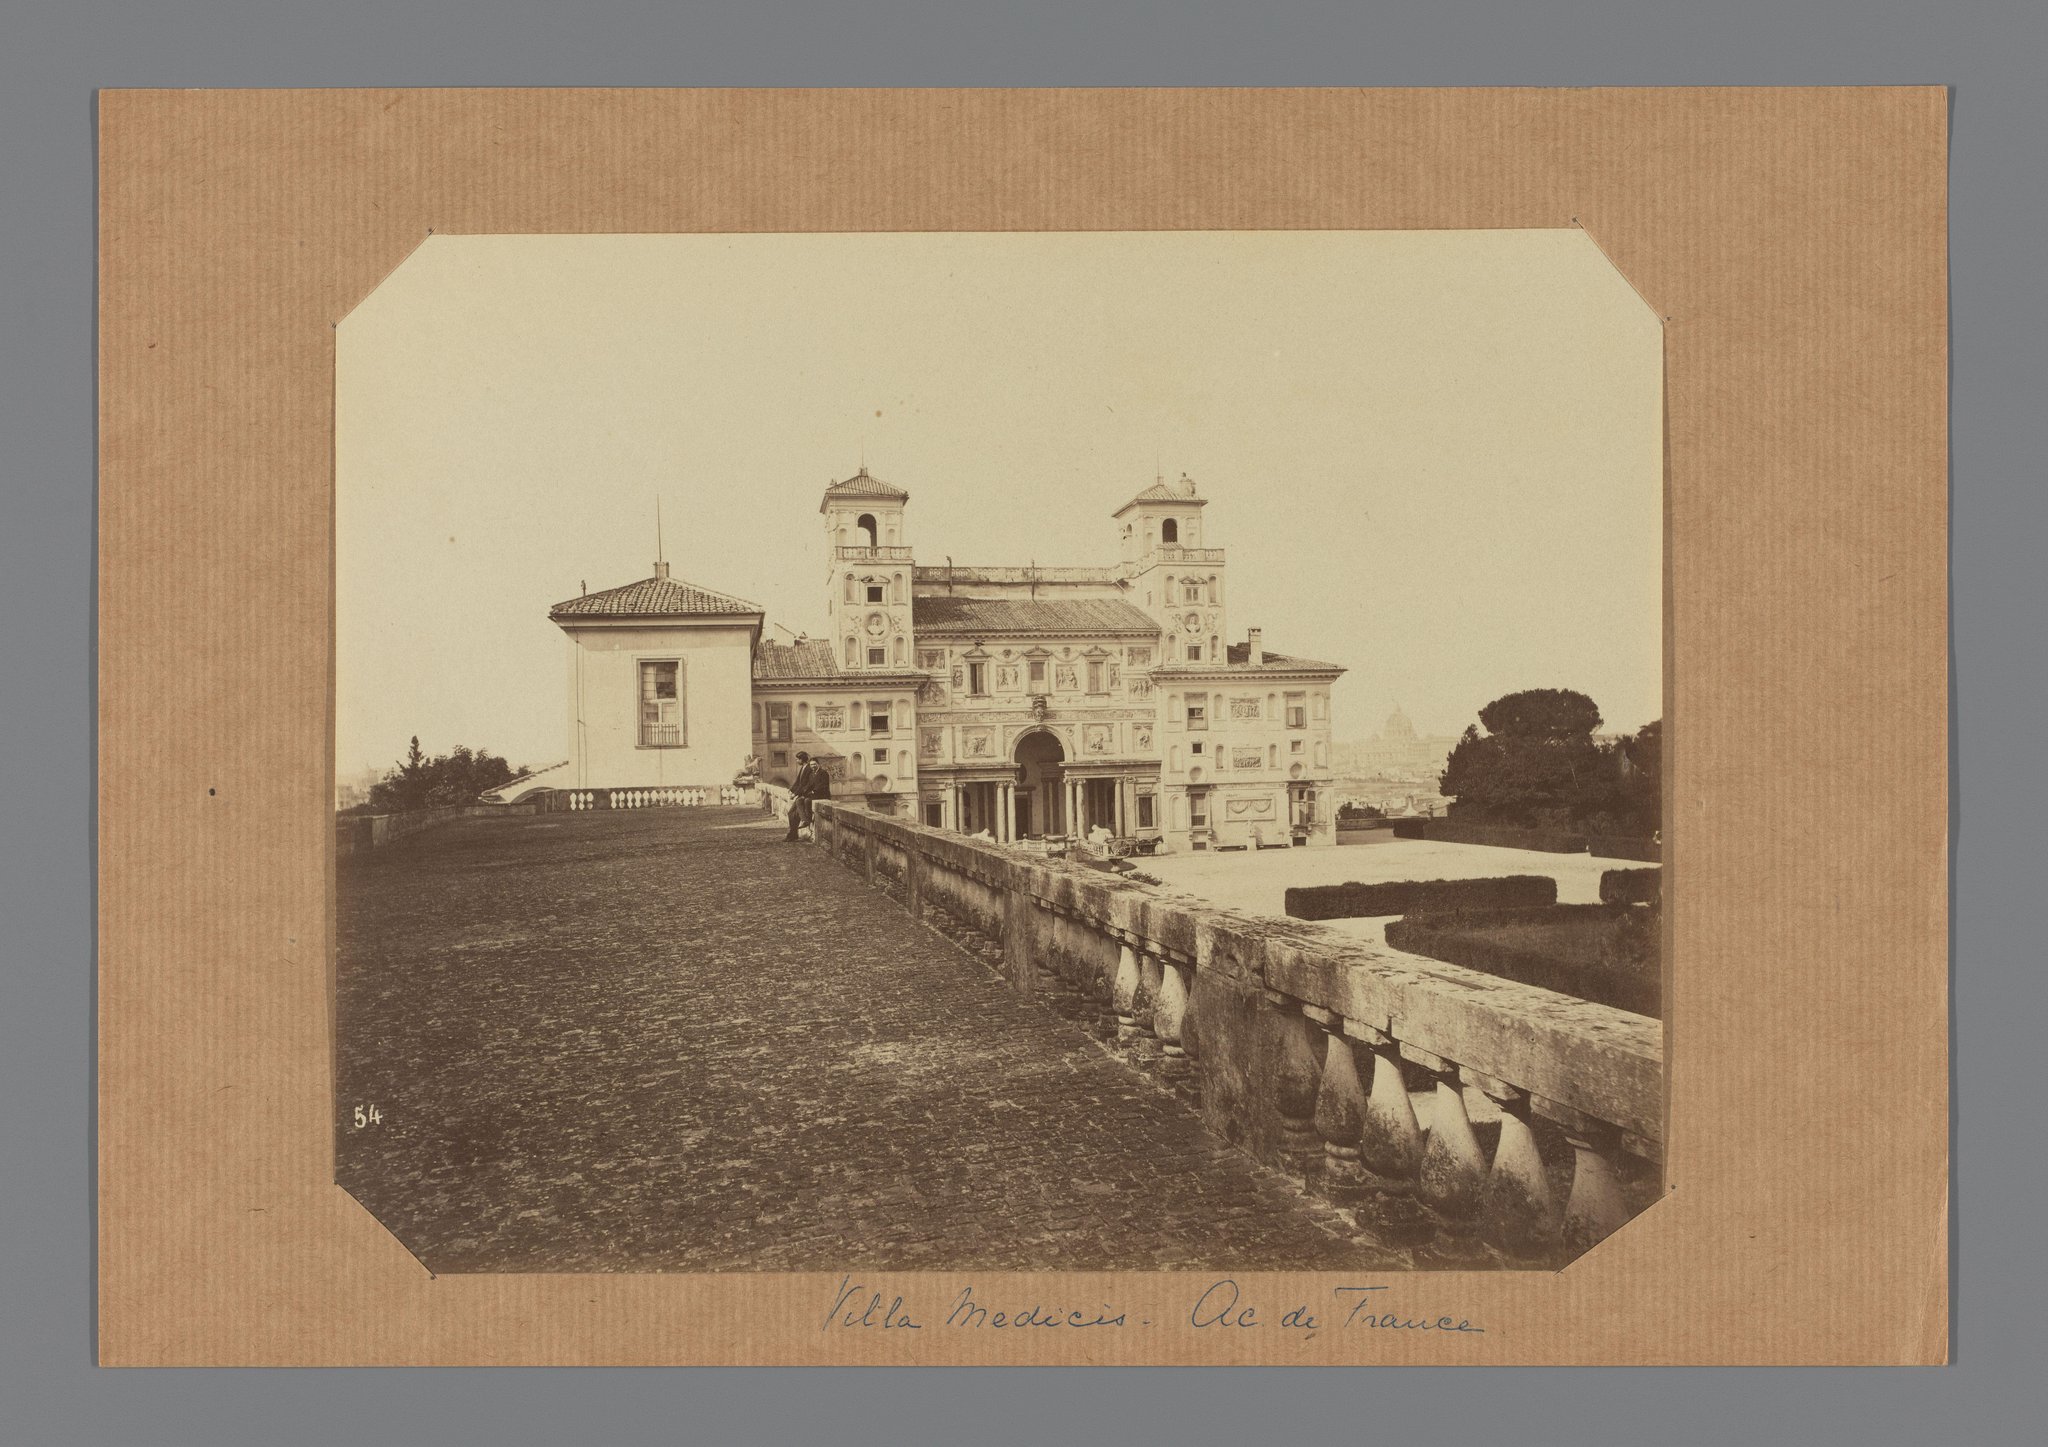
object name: photograph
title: Villa Medicci Ac. de France, Rome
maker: Anonymous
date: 1850-1899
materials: paper, photographic support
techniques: albumen print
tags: villa medici